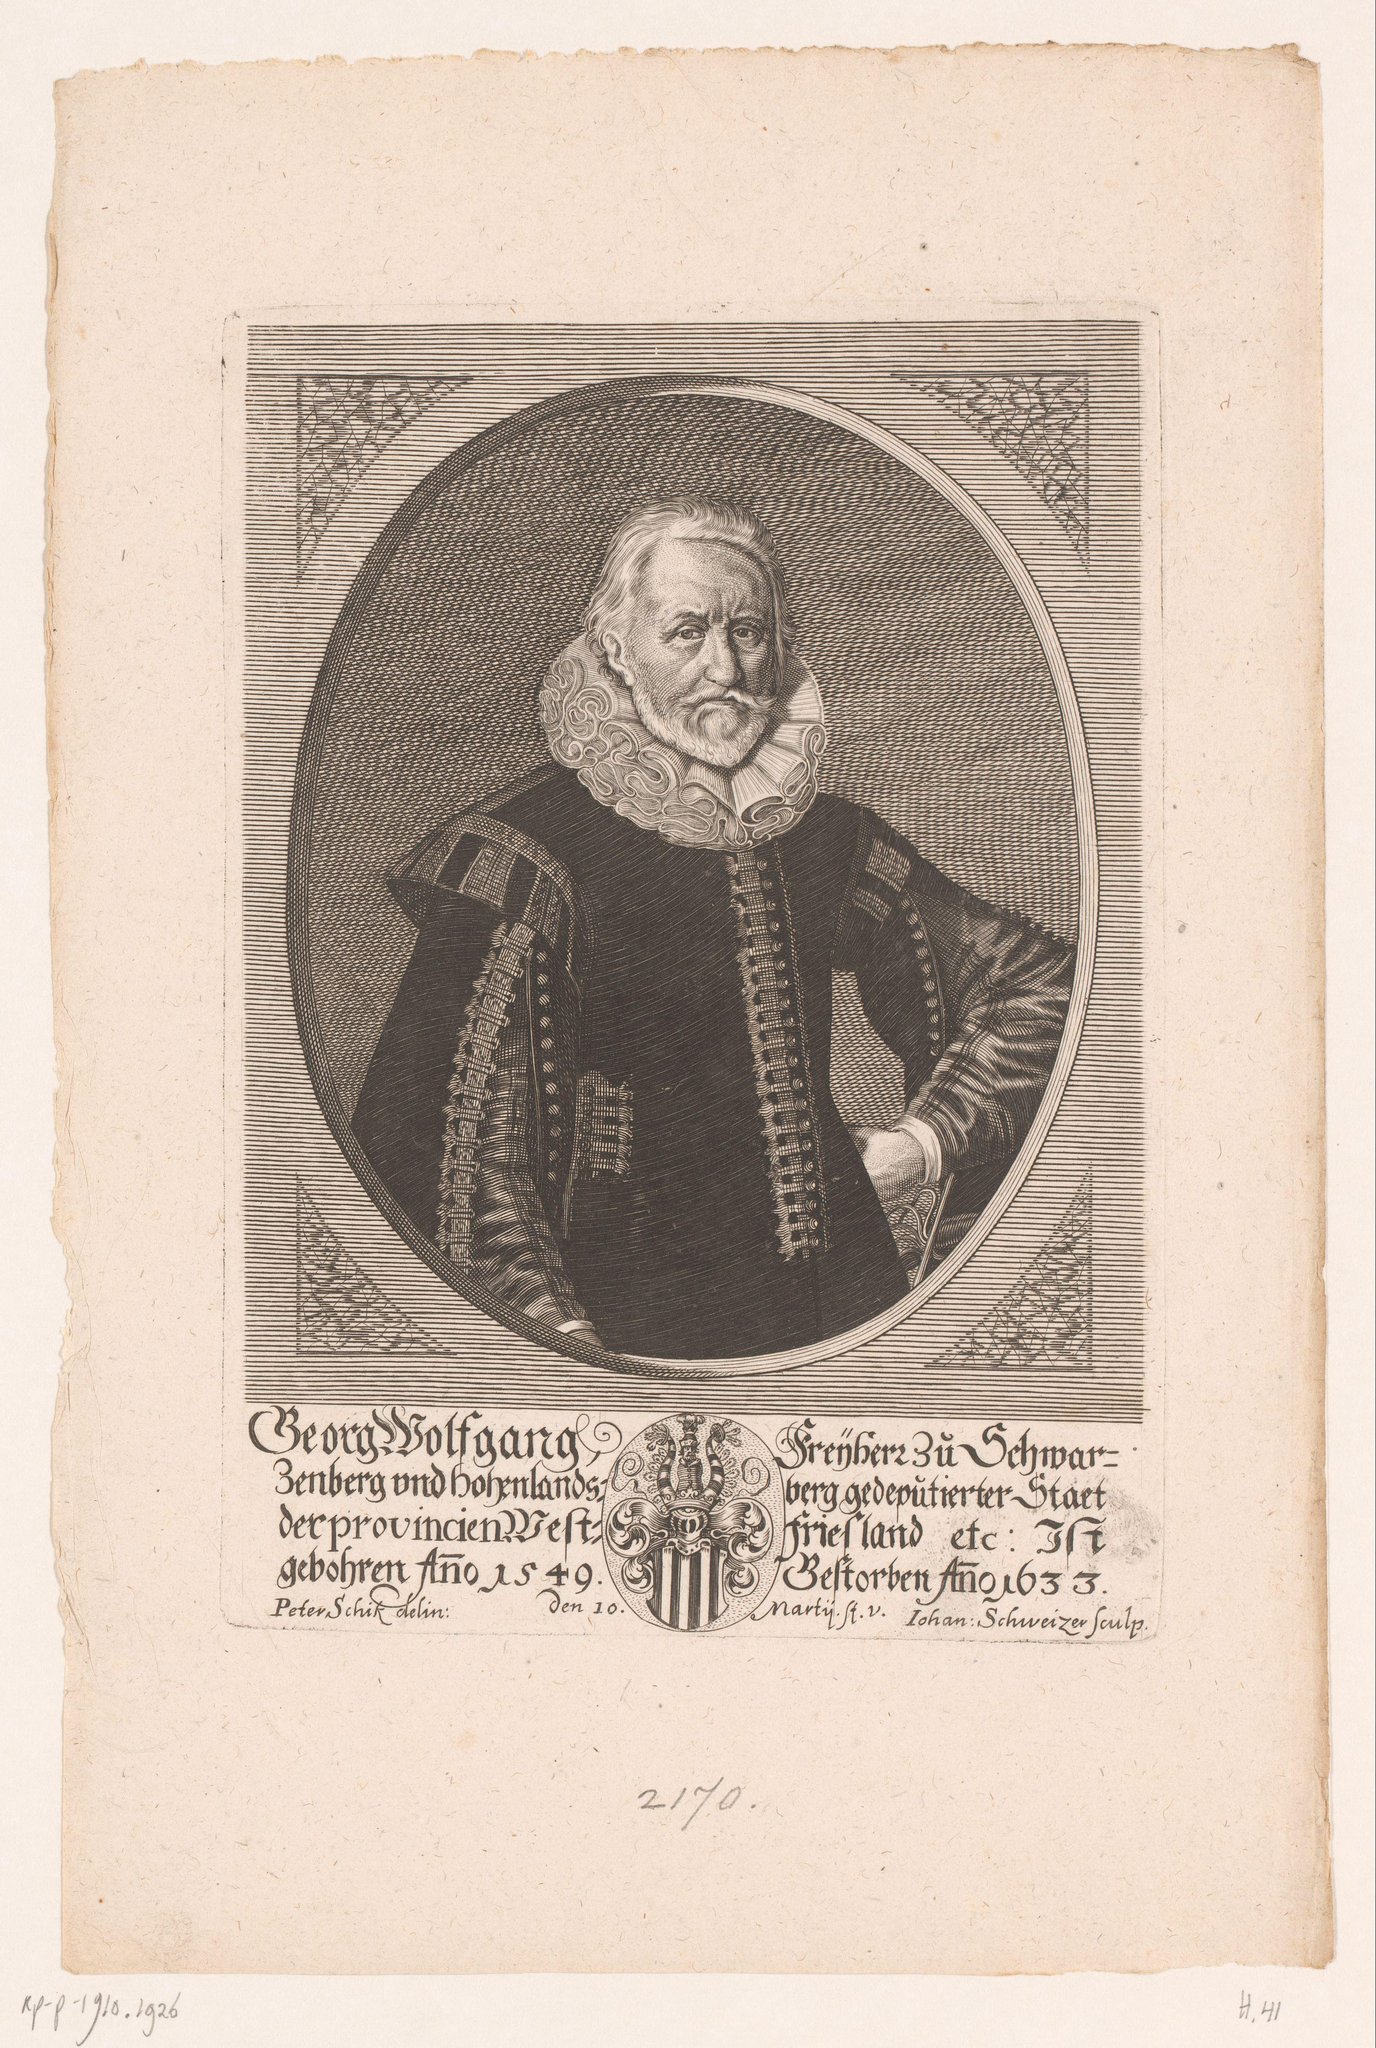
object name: print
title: Leden van de familie Schwarzenberg-Hohelandsberg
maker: johann schweizer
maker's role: print maker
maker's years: 1625-1670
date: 1640-1670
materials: paper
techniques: engraving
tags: historical persons, armorial bearing, heraldry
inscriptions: collector's mark: Lugt 2228